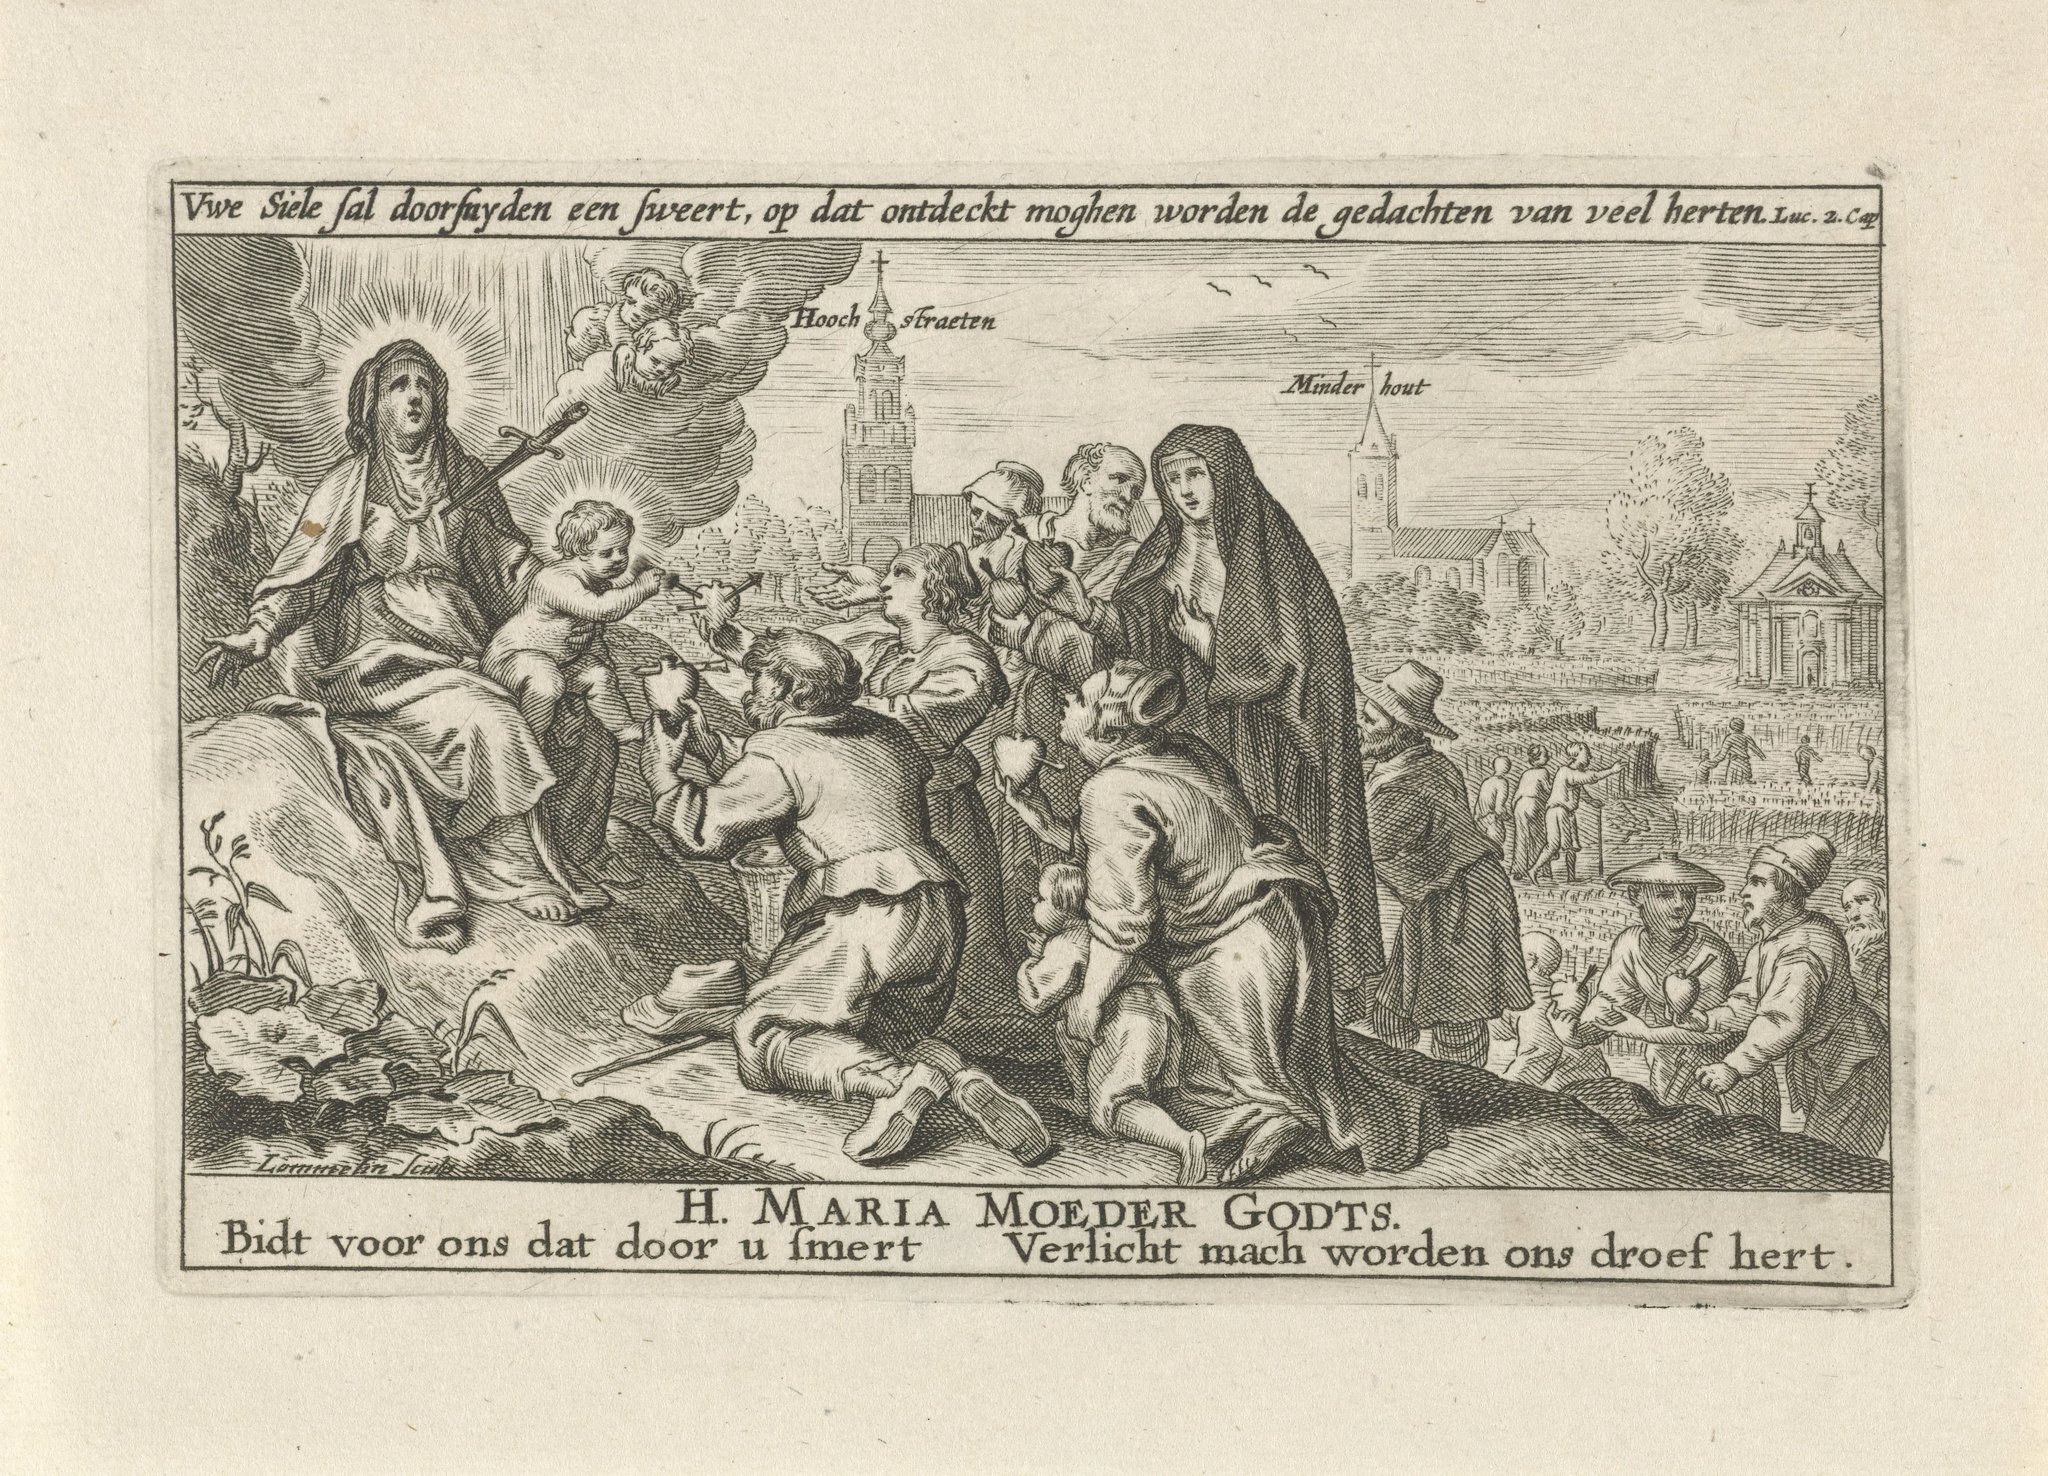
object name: print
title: H. Maria Moeder Godts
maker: adriaen lommelin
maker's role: print maker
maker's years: 1618-1675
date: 1630-1677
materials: paper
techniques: engraving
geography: antwerp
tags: madonna: i.e. mary with the christ-child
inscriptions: collector's mark: Lugt 2228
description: Maria zit met het Christuskind op schoot, haar hart is met een dolk doorboord. Het Christuskind wordt door de inwoners van Hoogstraten en Minderhout aanbeden. In de verte de kerktorens van deze steden. Boven de voorstelling een bijbelvers in het Nederlands, Luc. 2. In de marge een tweeregelig Nederlands onderschrift.